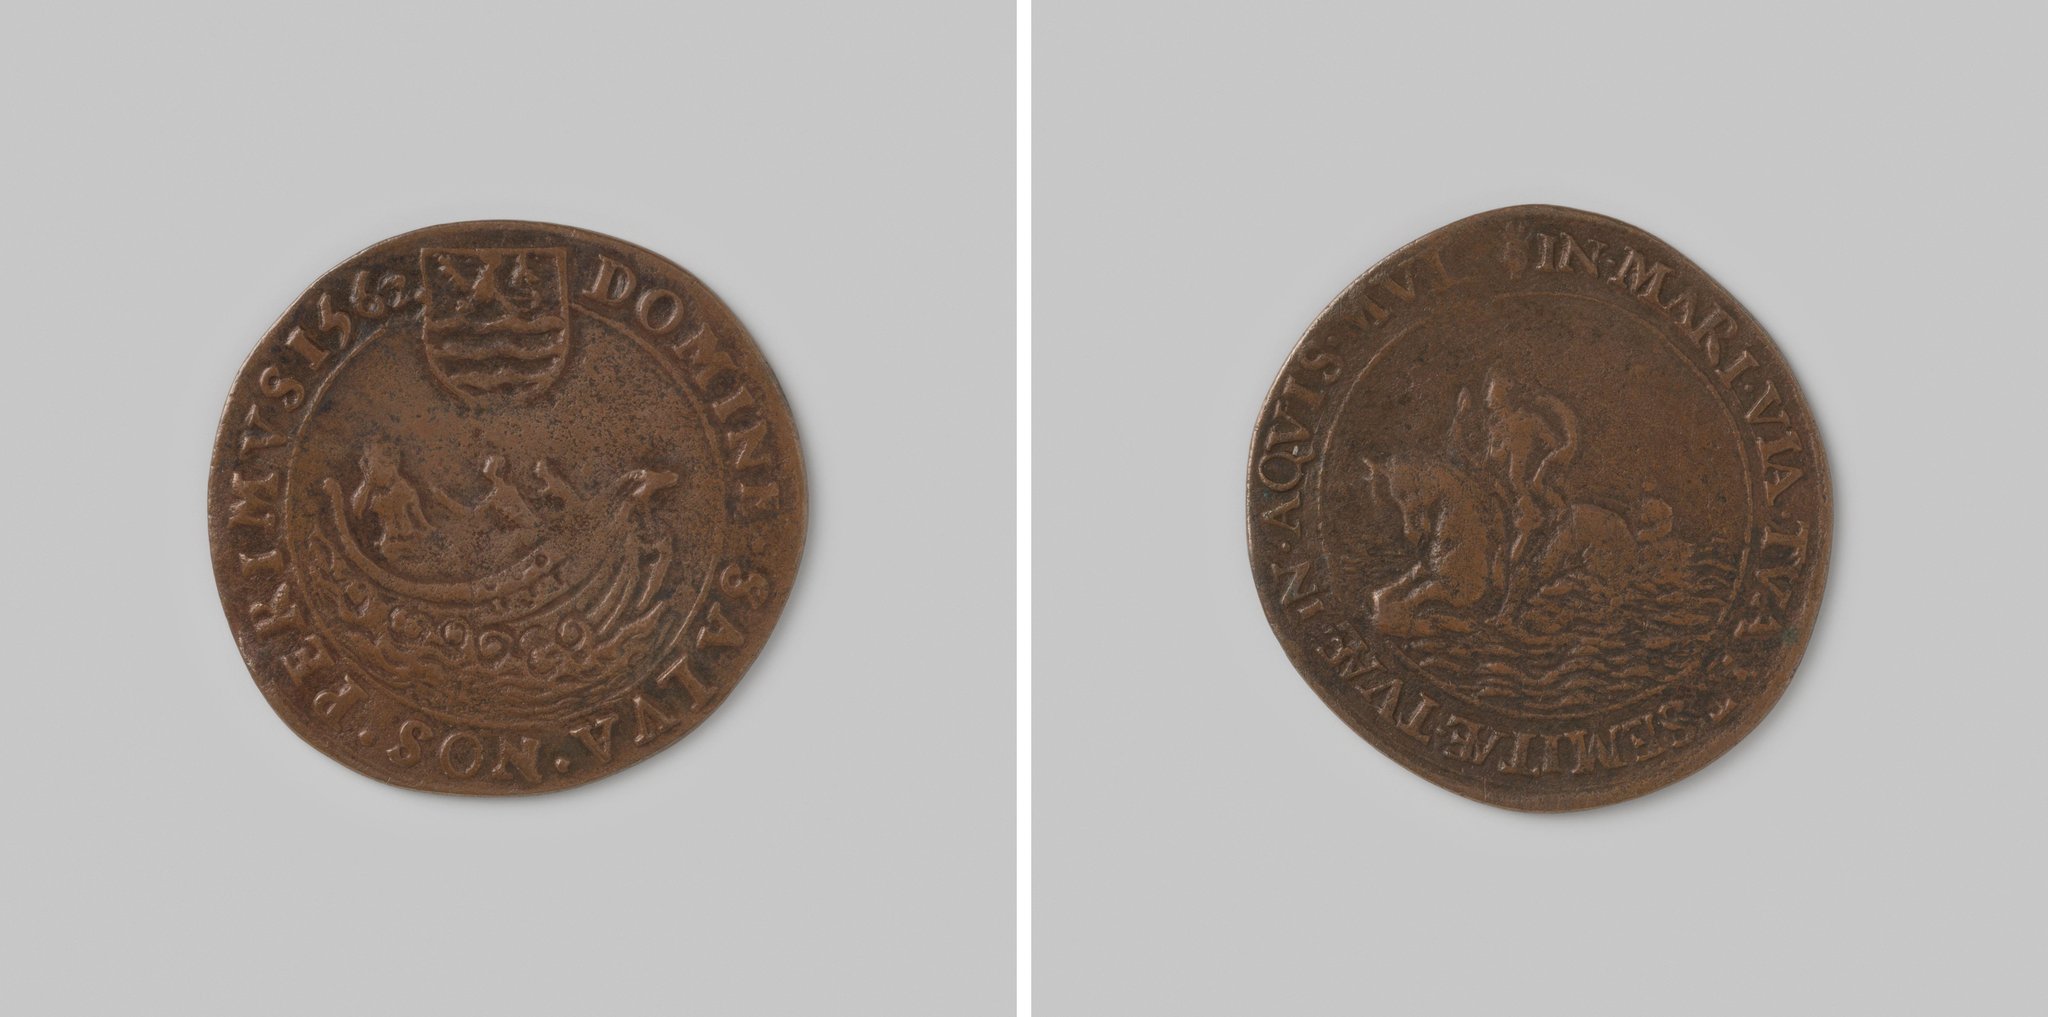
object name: history medal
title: Rekenpenning uit Antwerpen voor Zeeland op de moeilijke tijden 1562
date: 1562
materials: copper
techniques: striking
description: Koperen penning, op de voorzijde een schip in nood waarop Christus gewekt wordt, onder het wapenschild van Zeeland, met omschrift, op de keerzijde de Koning op een hippocampus naar links, met omschrift.